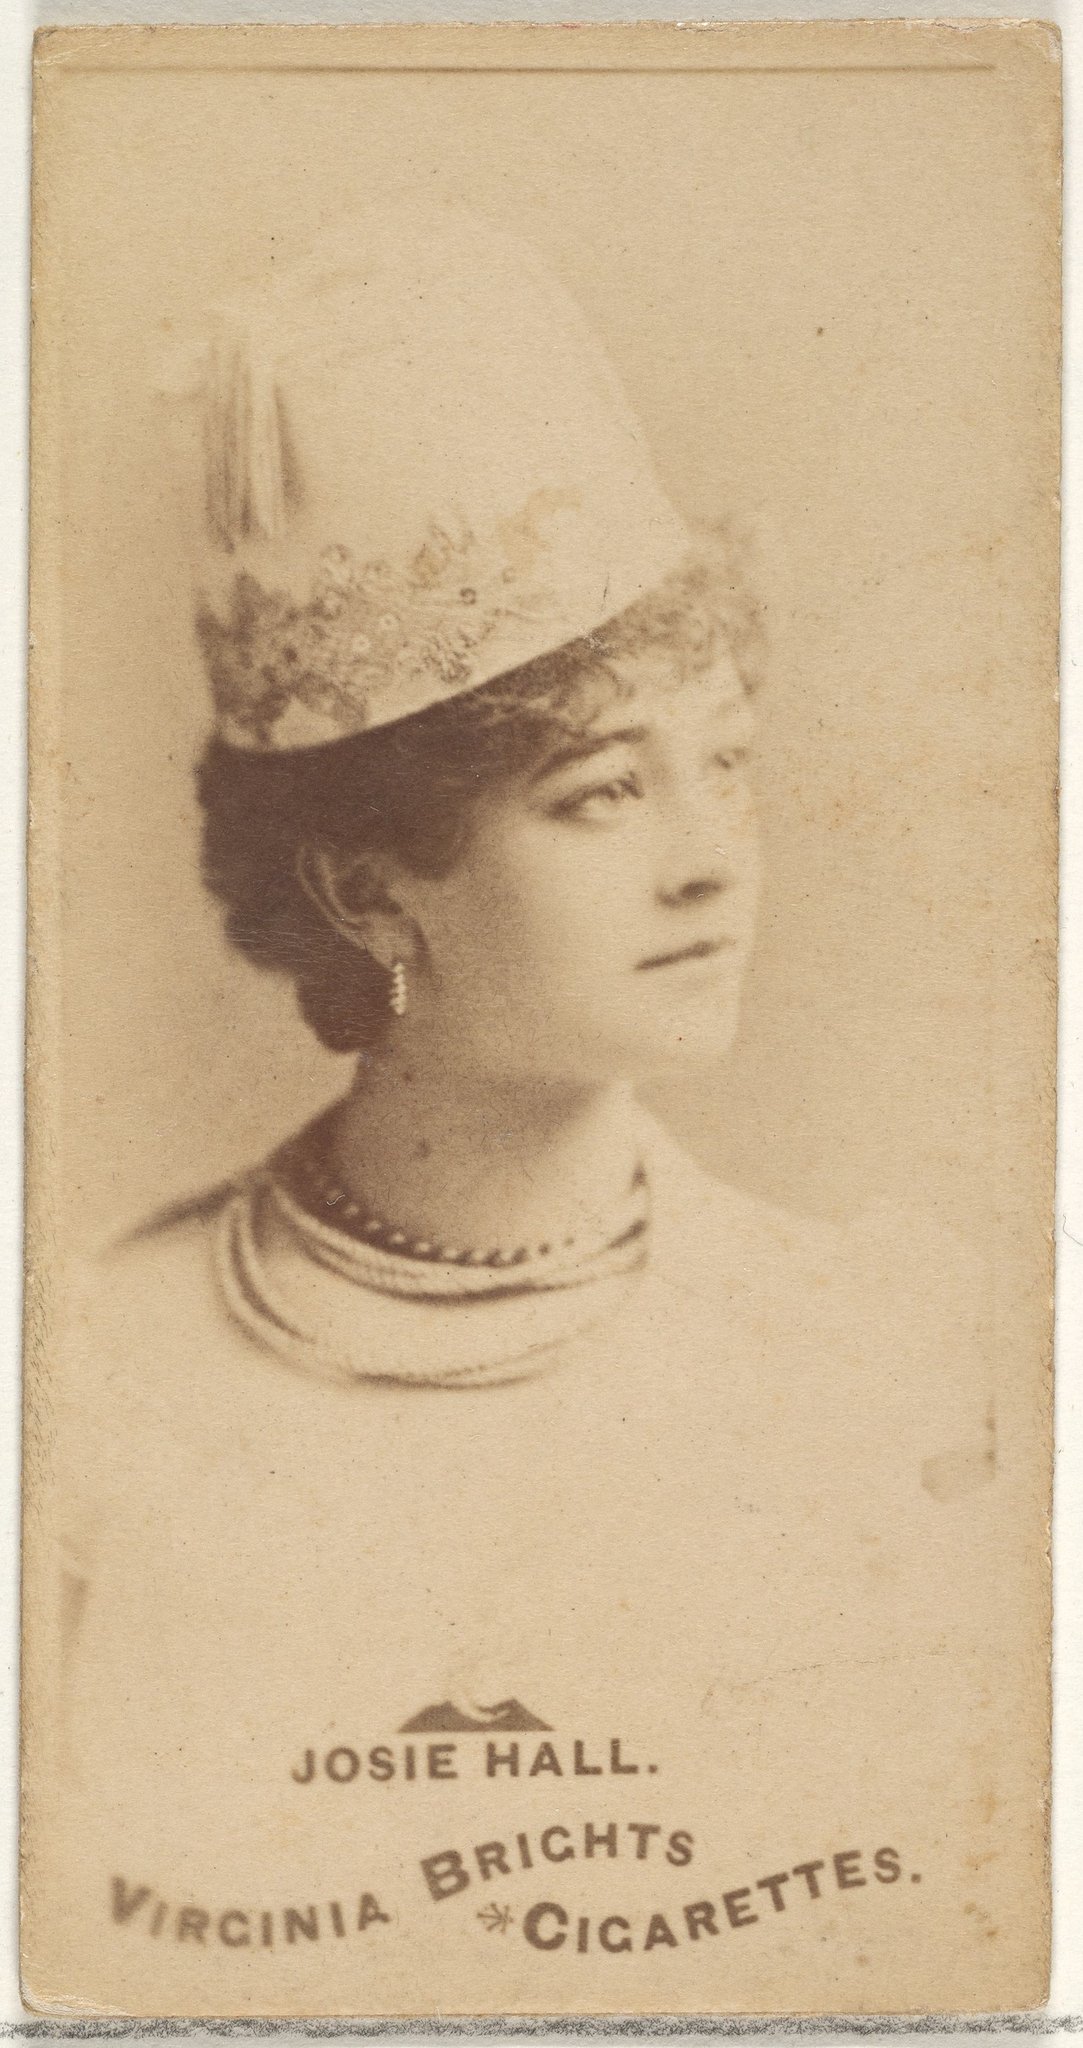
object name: photograph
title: Josie Hall, from the Actors and Actresses series (N45, Type 1) for Virginia Brights Cigarettes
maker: allen & ginter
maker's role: publisher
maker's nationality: american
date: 1888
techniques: albumen silver print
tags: portraits,women,actresses